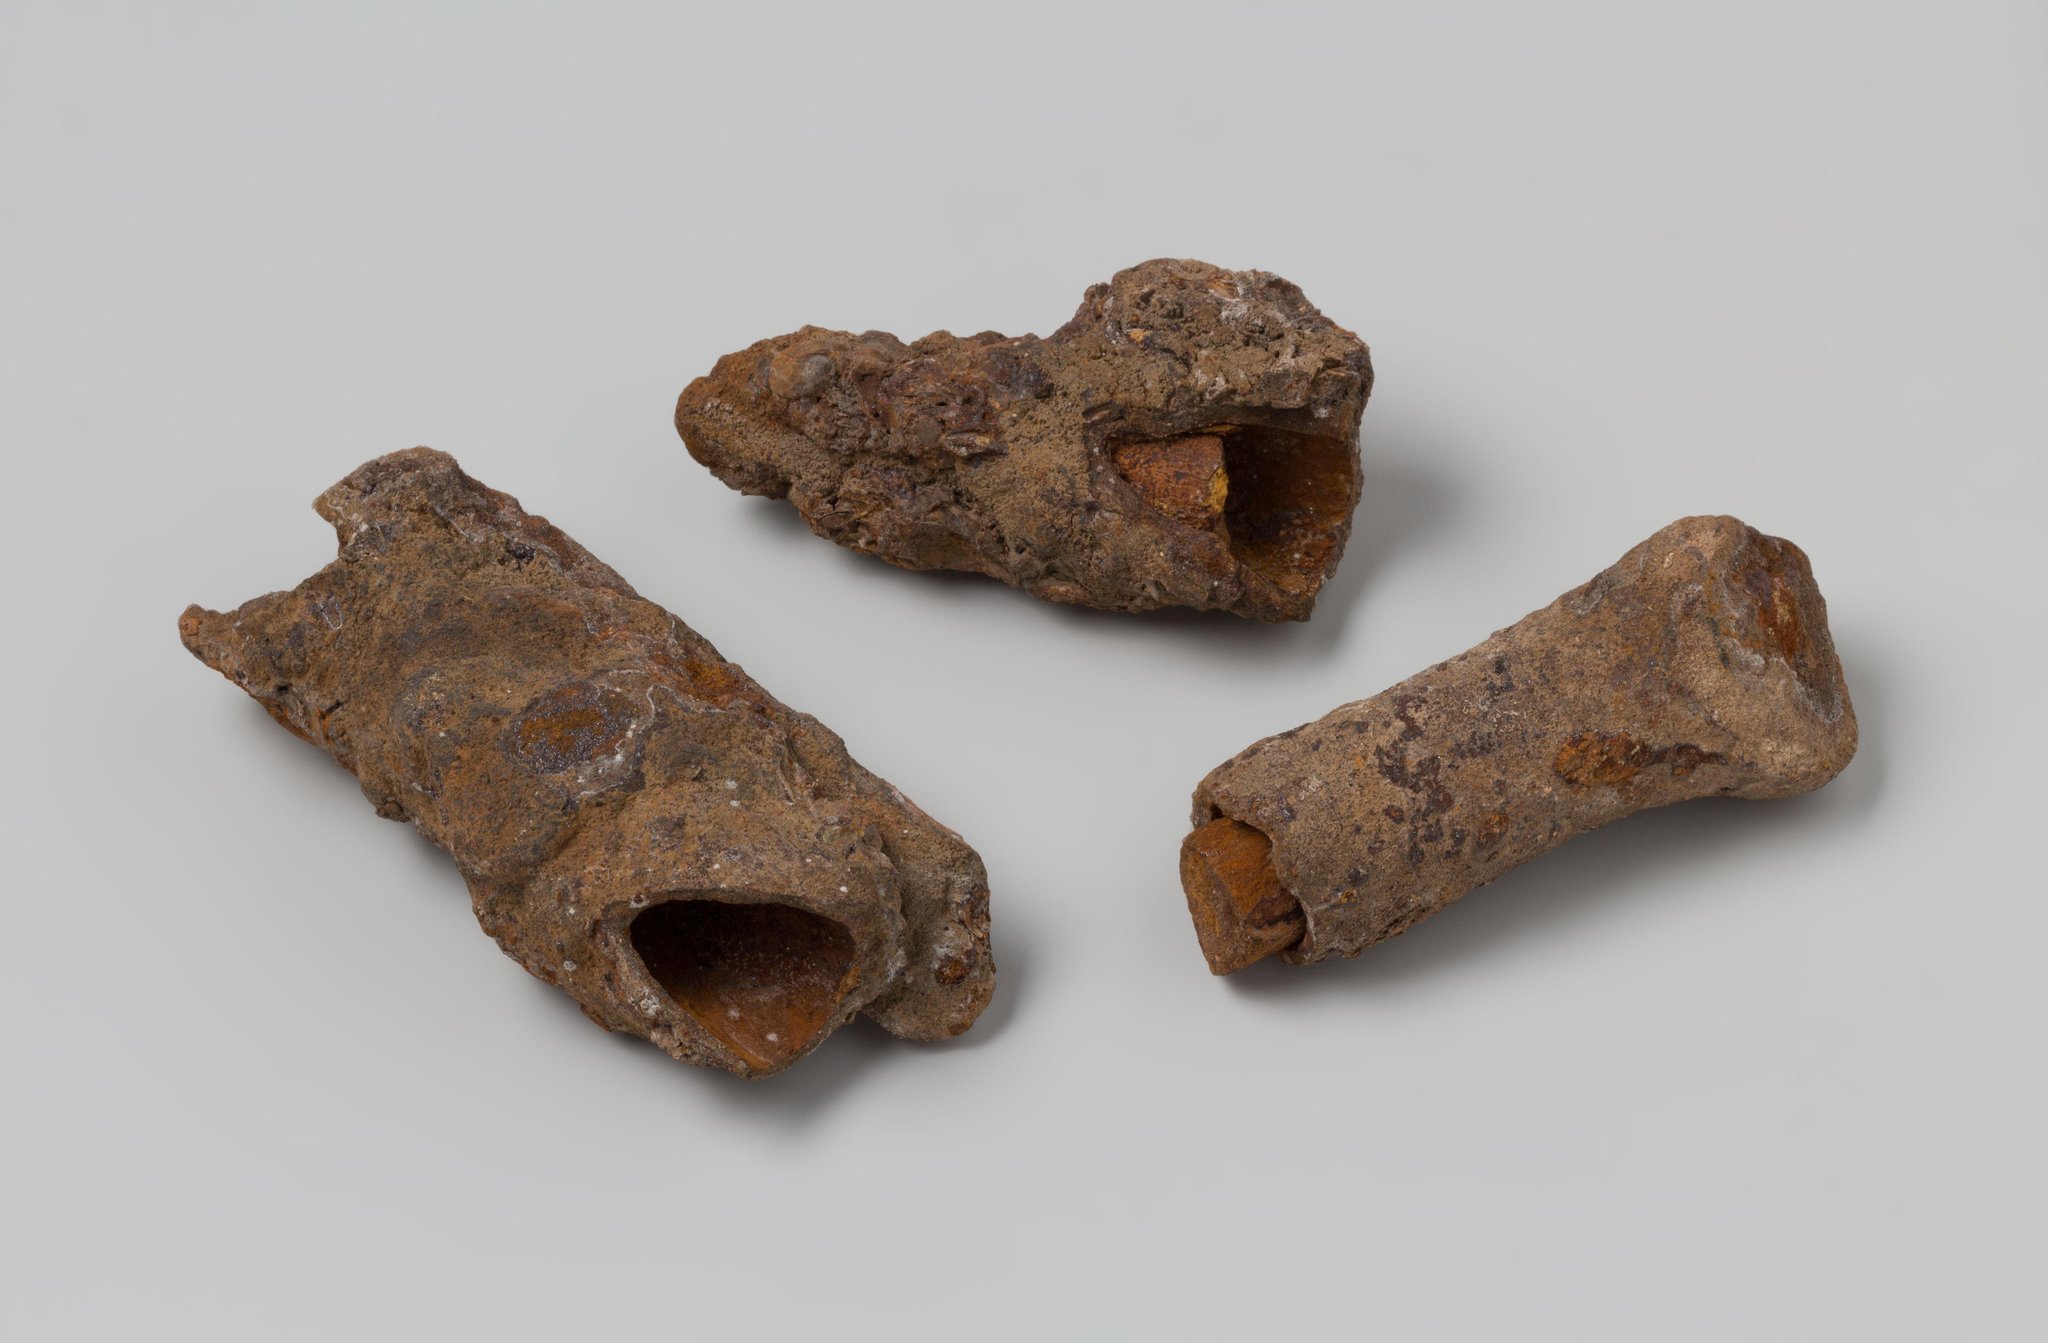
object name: concretionary stone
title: Drietal ijzerconcretiez warin de resten van houten pennen uit het wrak van de in 1735 vergane Oost-Indiëvaarder 't Vliegend Hart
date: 1700-1735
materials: stone, wood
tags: 't vliegend hart (schip), verenigde oostindische compagnie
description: Delen van een houten pen zijn bijna volledig ingesloten door concretie.